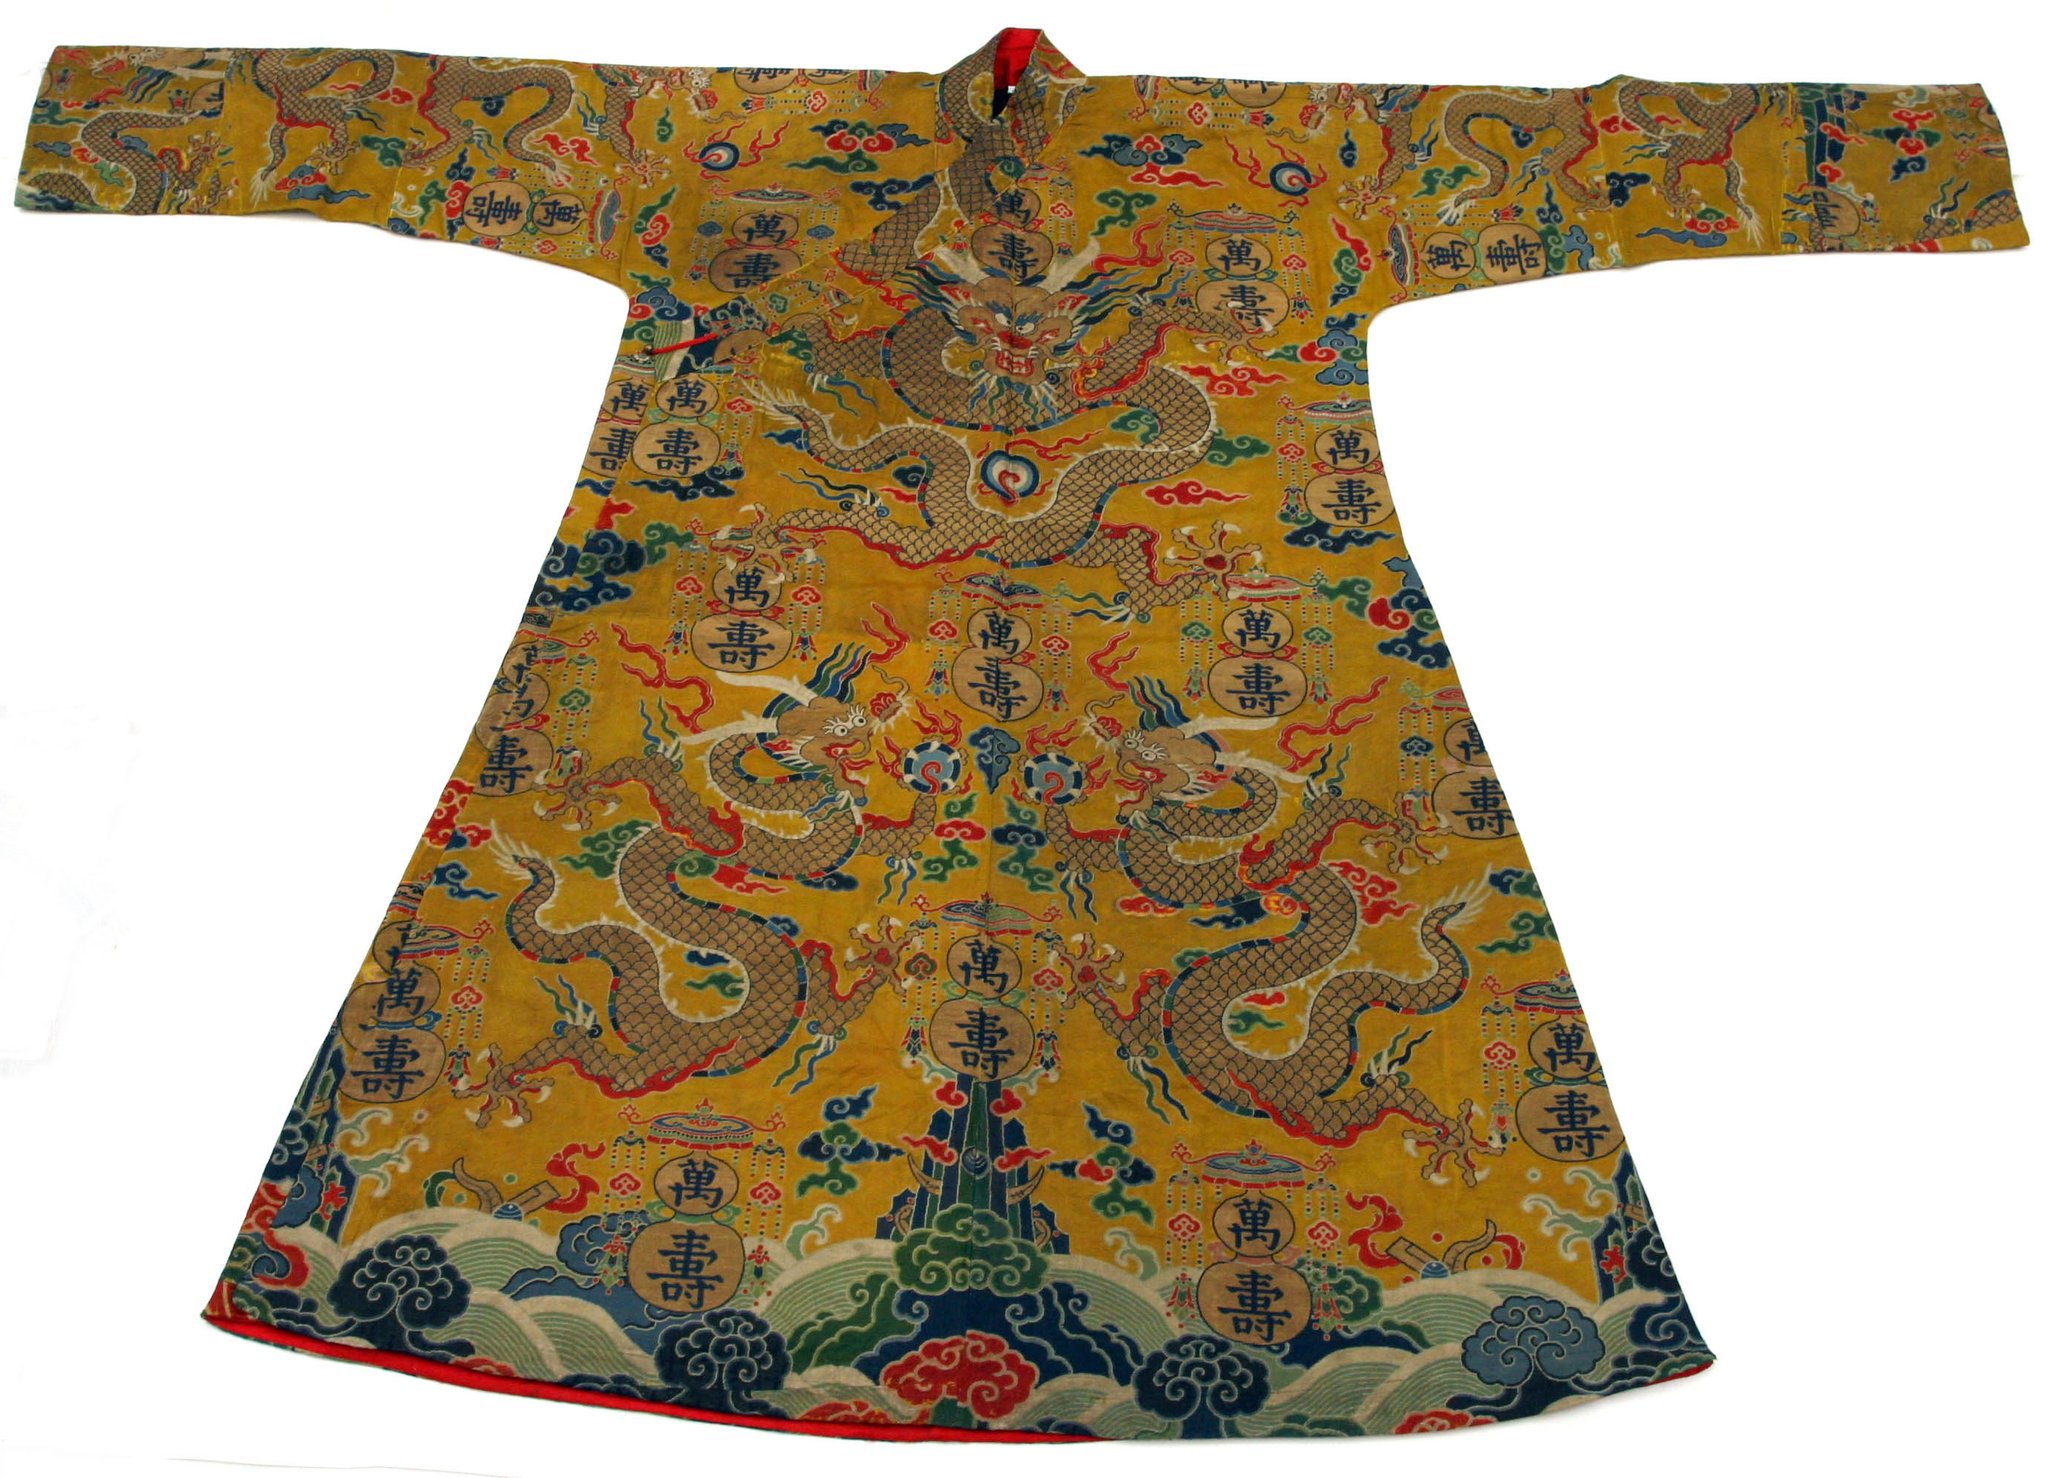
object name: robe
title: Lay Aristocrat's Robe (Chuba)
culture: tibetan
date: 1701-1900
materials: gold, silk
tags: dragons